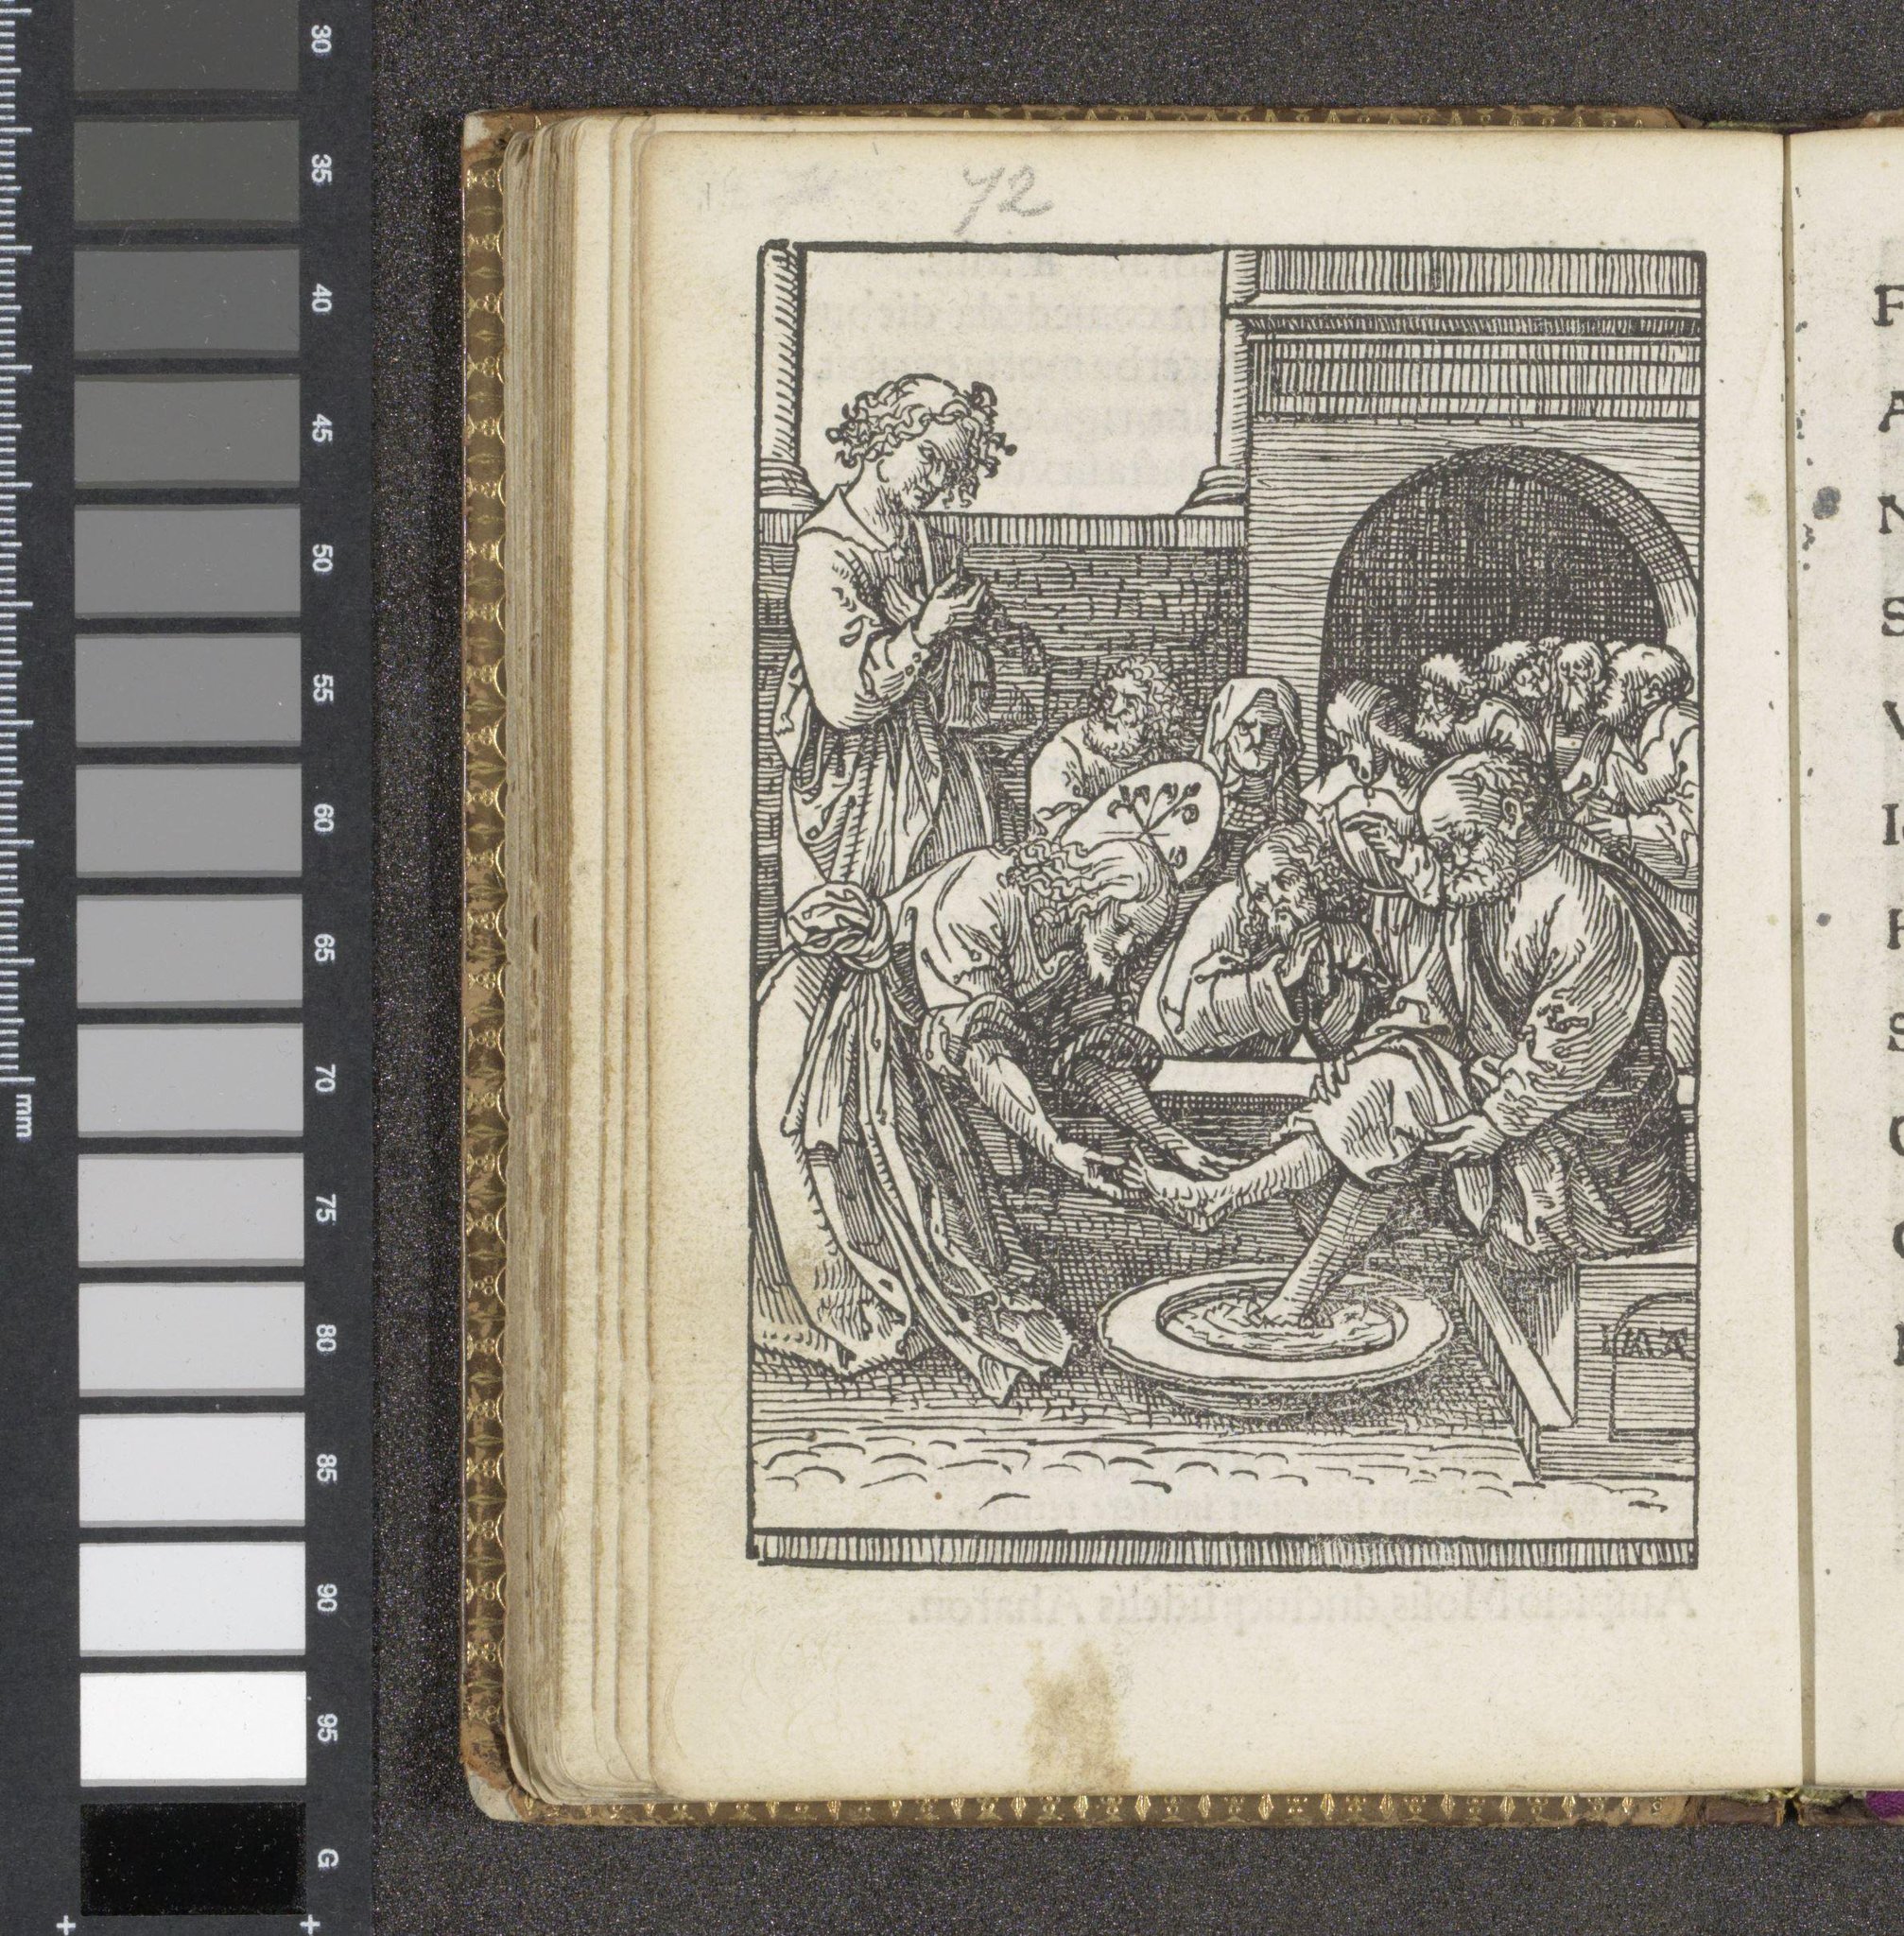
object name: print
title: Voetwassing van Petrus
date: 1523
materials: paper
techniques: woodcut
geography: amsterdam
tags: christ washes peter's feet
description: Christus wast de voeten van Petrus. De andere discipelen kijken toe. Prent maakt deel uit van een boek.